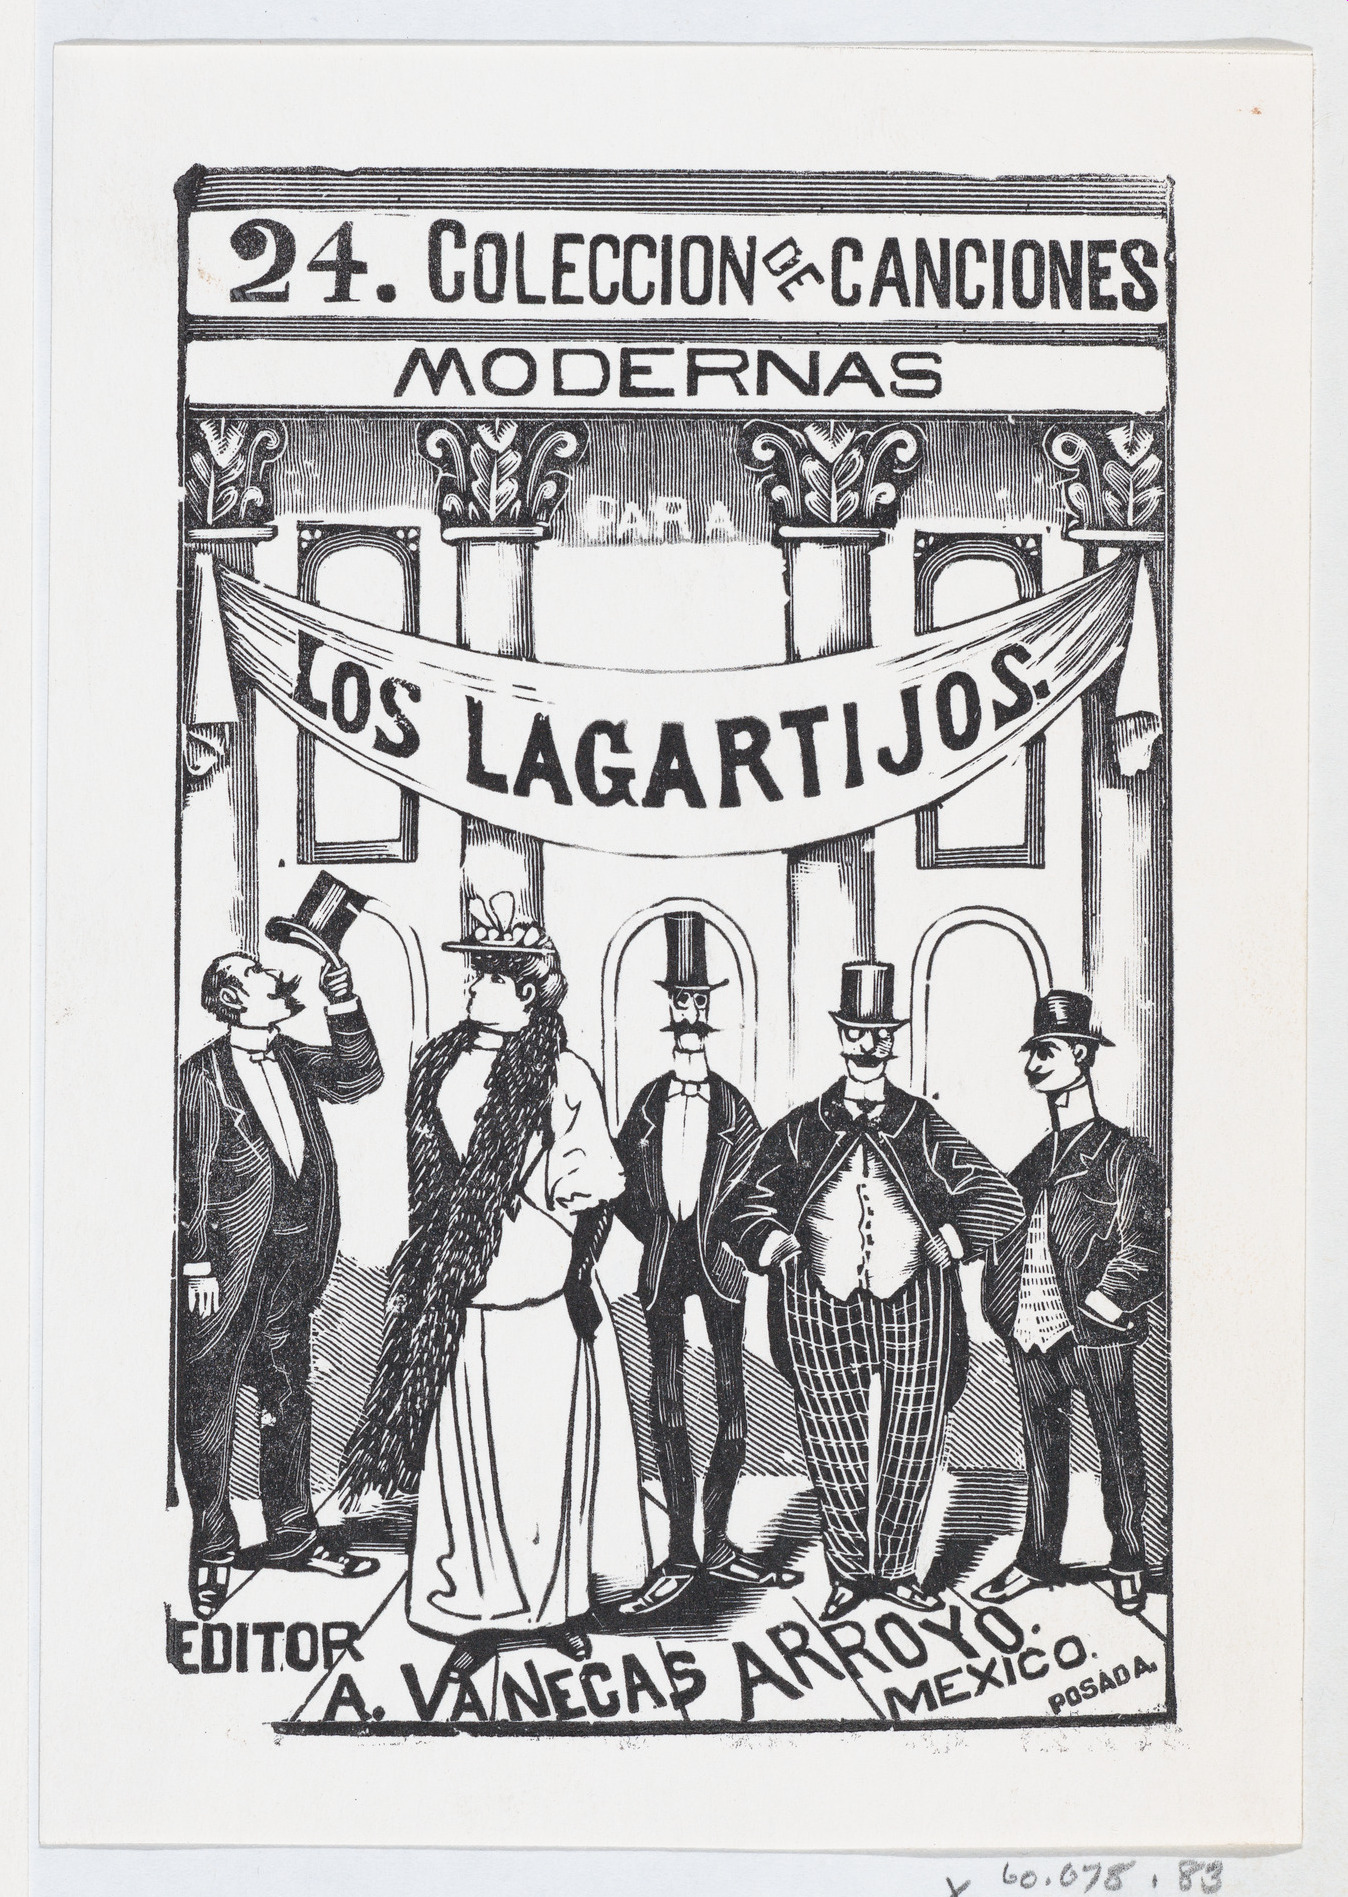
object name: print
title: Four men and one woman in fine clothes standing in a line under a banner, illustration for 'Los Lagartijos (The Dandies)'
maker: josé guadalupe posada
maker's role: artist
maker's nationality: mexican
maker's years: 1852-1913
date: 1894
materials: metal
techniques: engraving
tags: men,women,flags